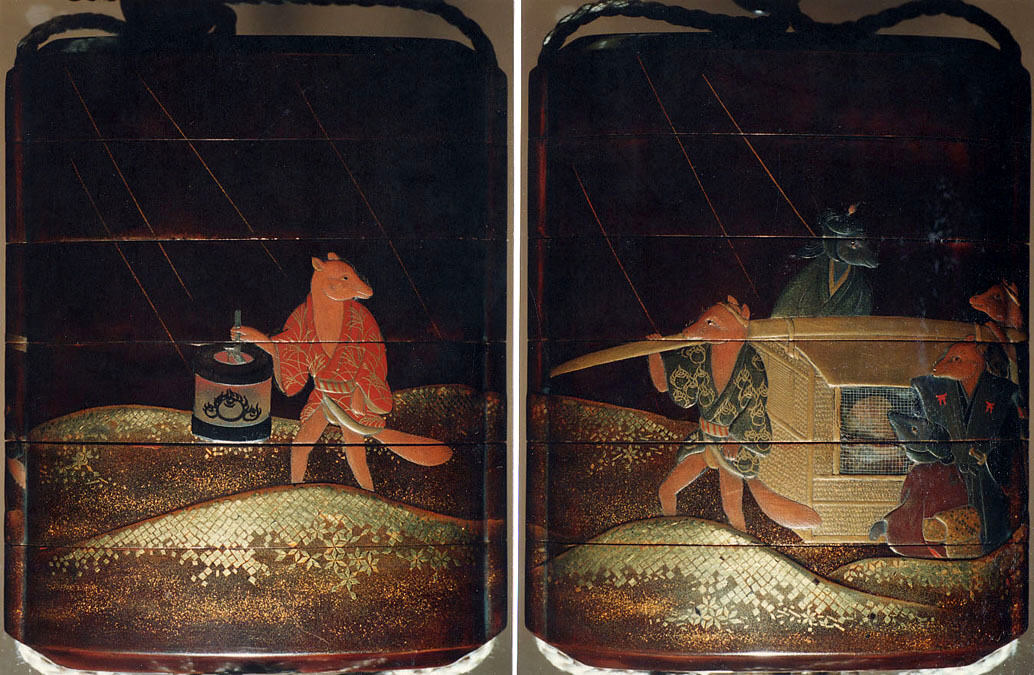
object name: inrō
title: Case (Inrō) with Design of Fox Wedding Procession in Rain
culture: japanese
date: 1801-1900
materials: gold, lacquer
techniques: fundame, hiramakie, maki-e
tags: foxes,rain